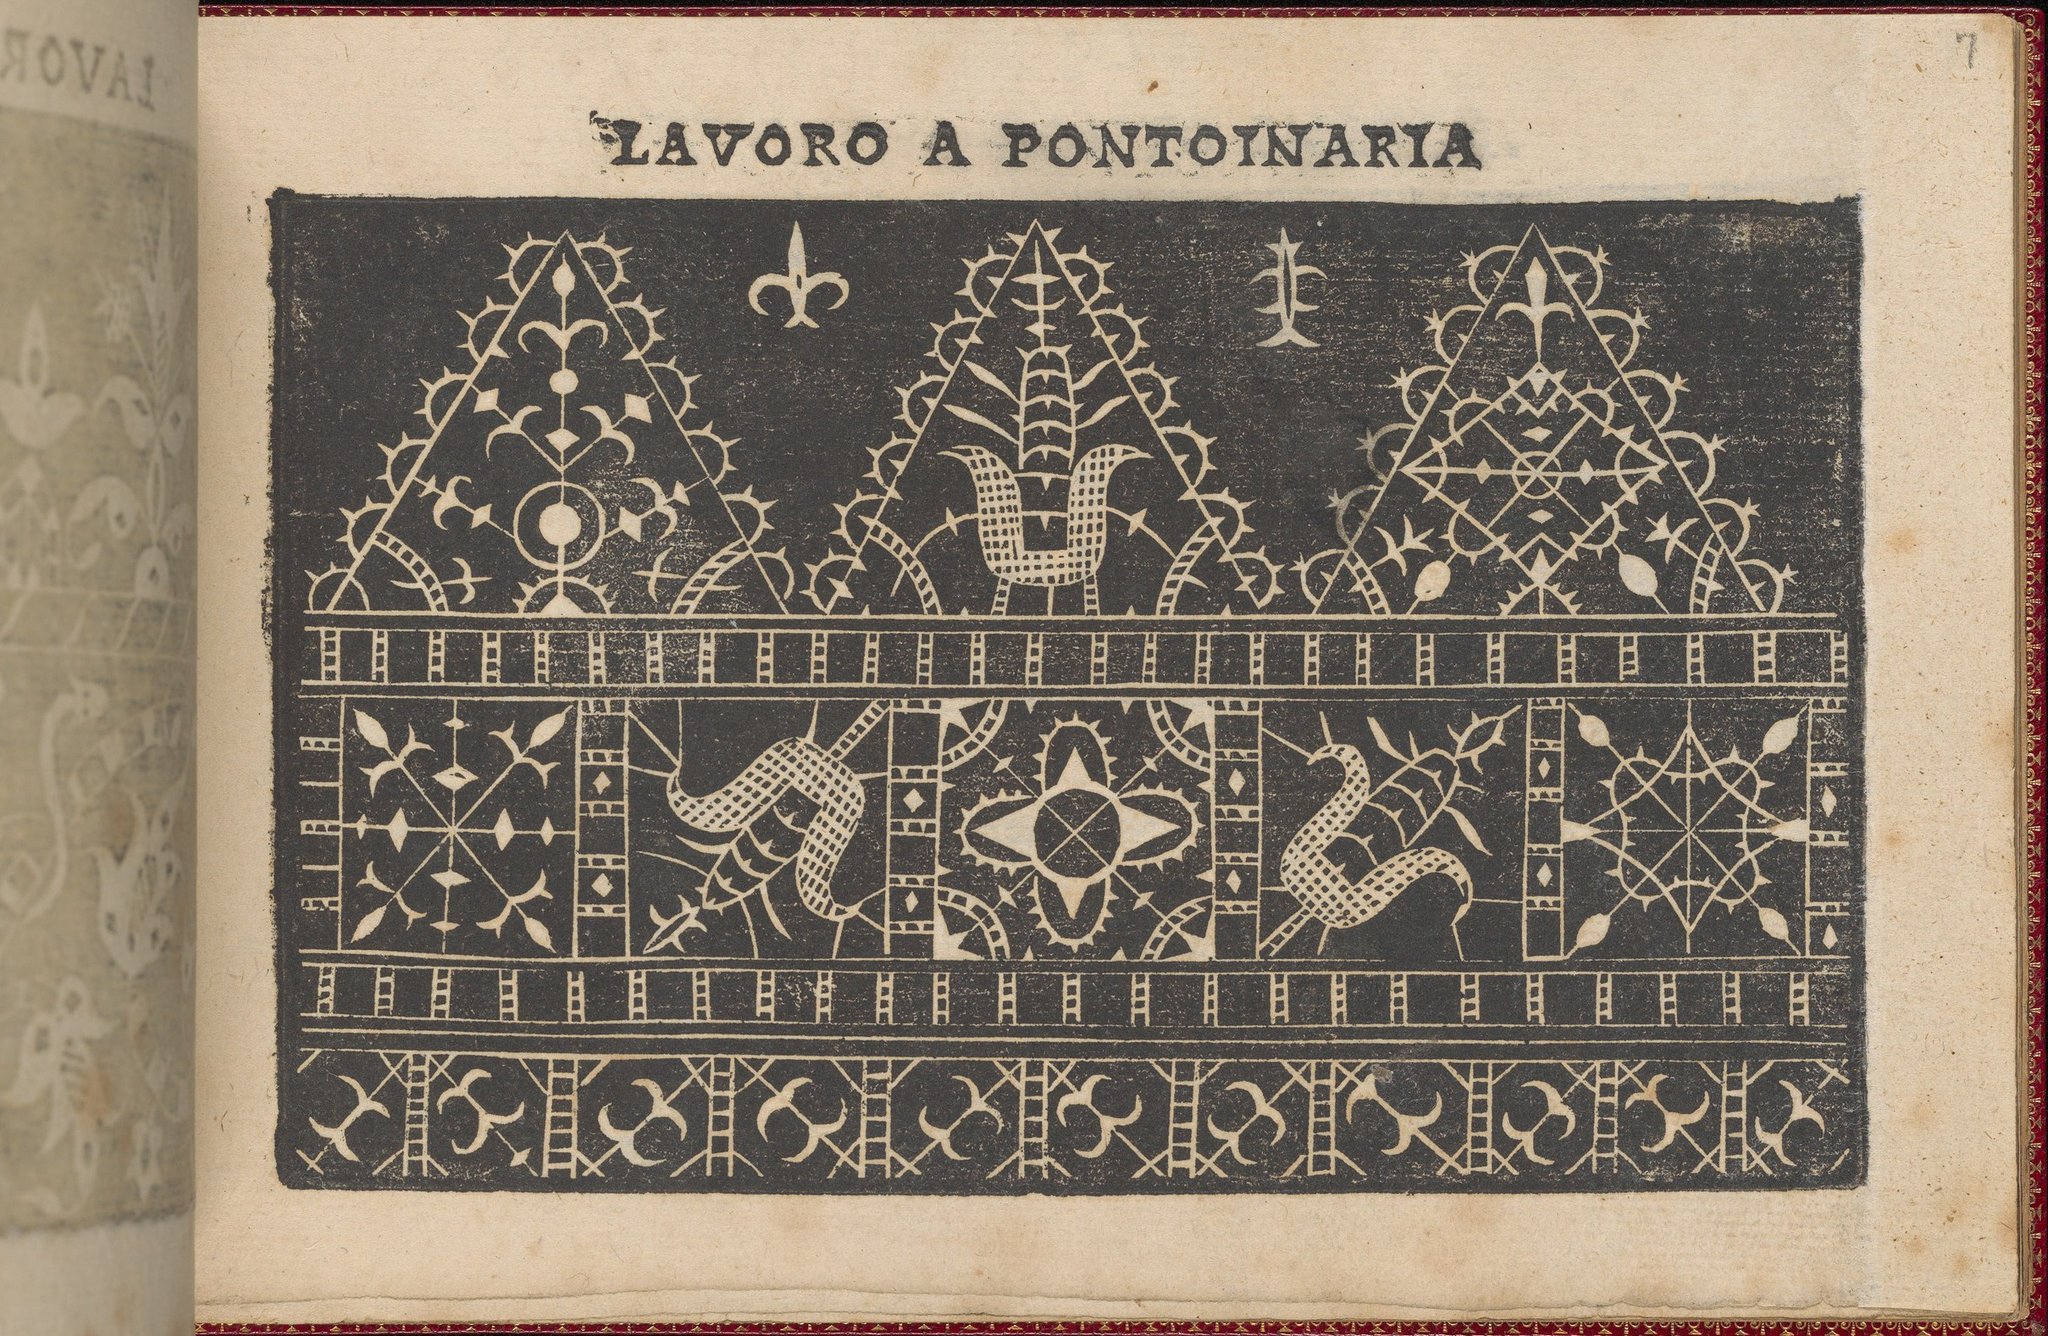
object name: book print ornament architecture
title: Pretiosa Gemma delle virtuose donne, page 9 (recto)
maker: isabella catanea parasole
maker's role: author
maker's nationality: italian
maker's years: 1565-1625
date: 1600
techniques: woodcut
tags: ornament